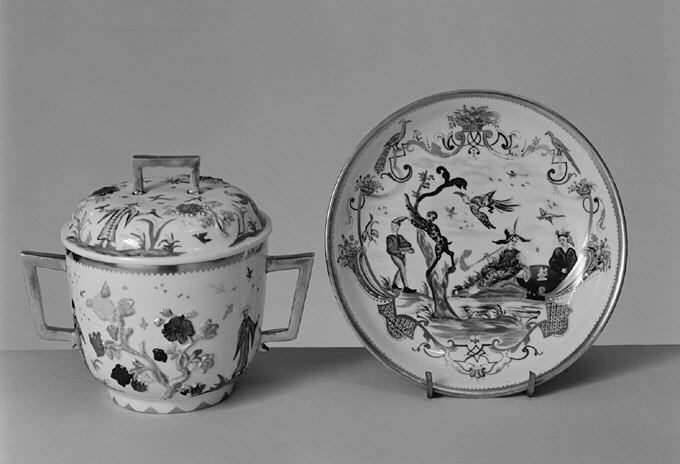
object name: bowl with cover and saucer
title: Circular bowl with cover and saucer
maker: meissen manufactory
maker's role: manufactory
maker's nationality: german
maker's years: 1710-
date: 1720-1725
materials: hard paste porcelain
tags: human figures,peacocks,flowers